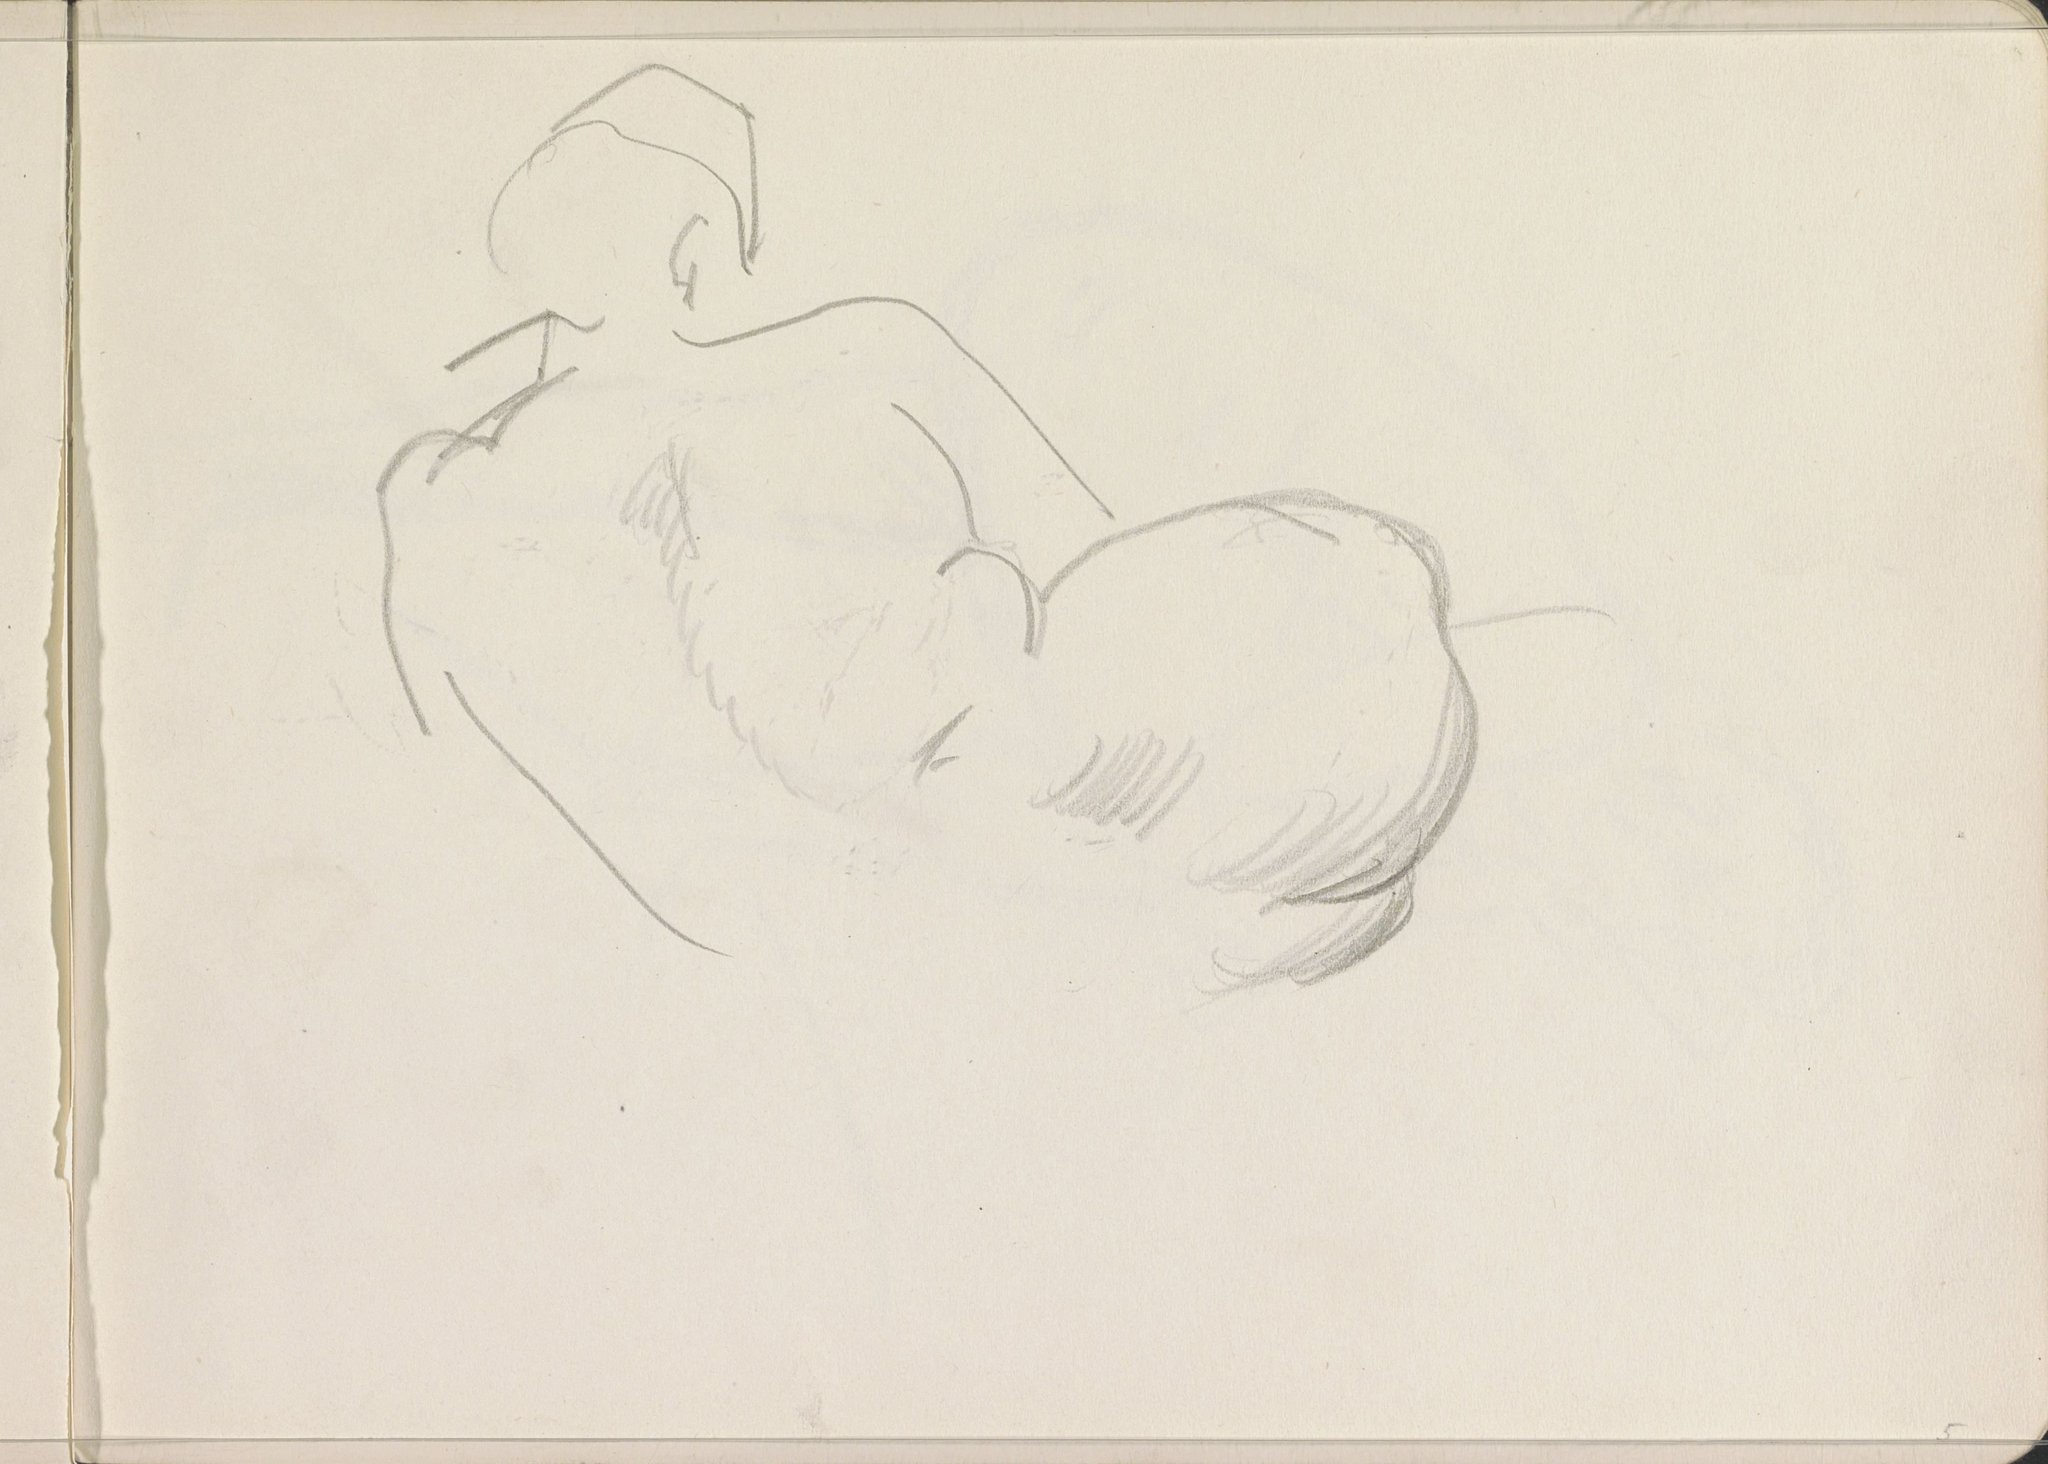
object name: sketchbook leaf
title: Liggend vrouwelijk naakt, op de rug gezien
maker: isaac israels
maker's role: draughtsman, painter, print maker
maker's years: 1865-1934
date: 1875-1934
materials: paper, pencil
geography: the hague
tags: the (nude) human figure; 'corpo humano' (ripa) - aa - female human figure (+ lying)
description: Blad 5 recto uit schetsboek II met 23 bladen.